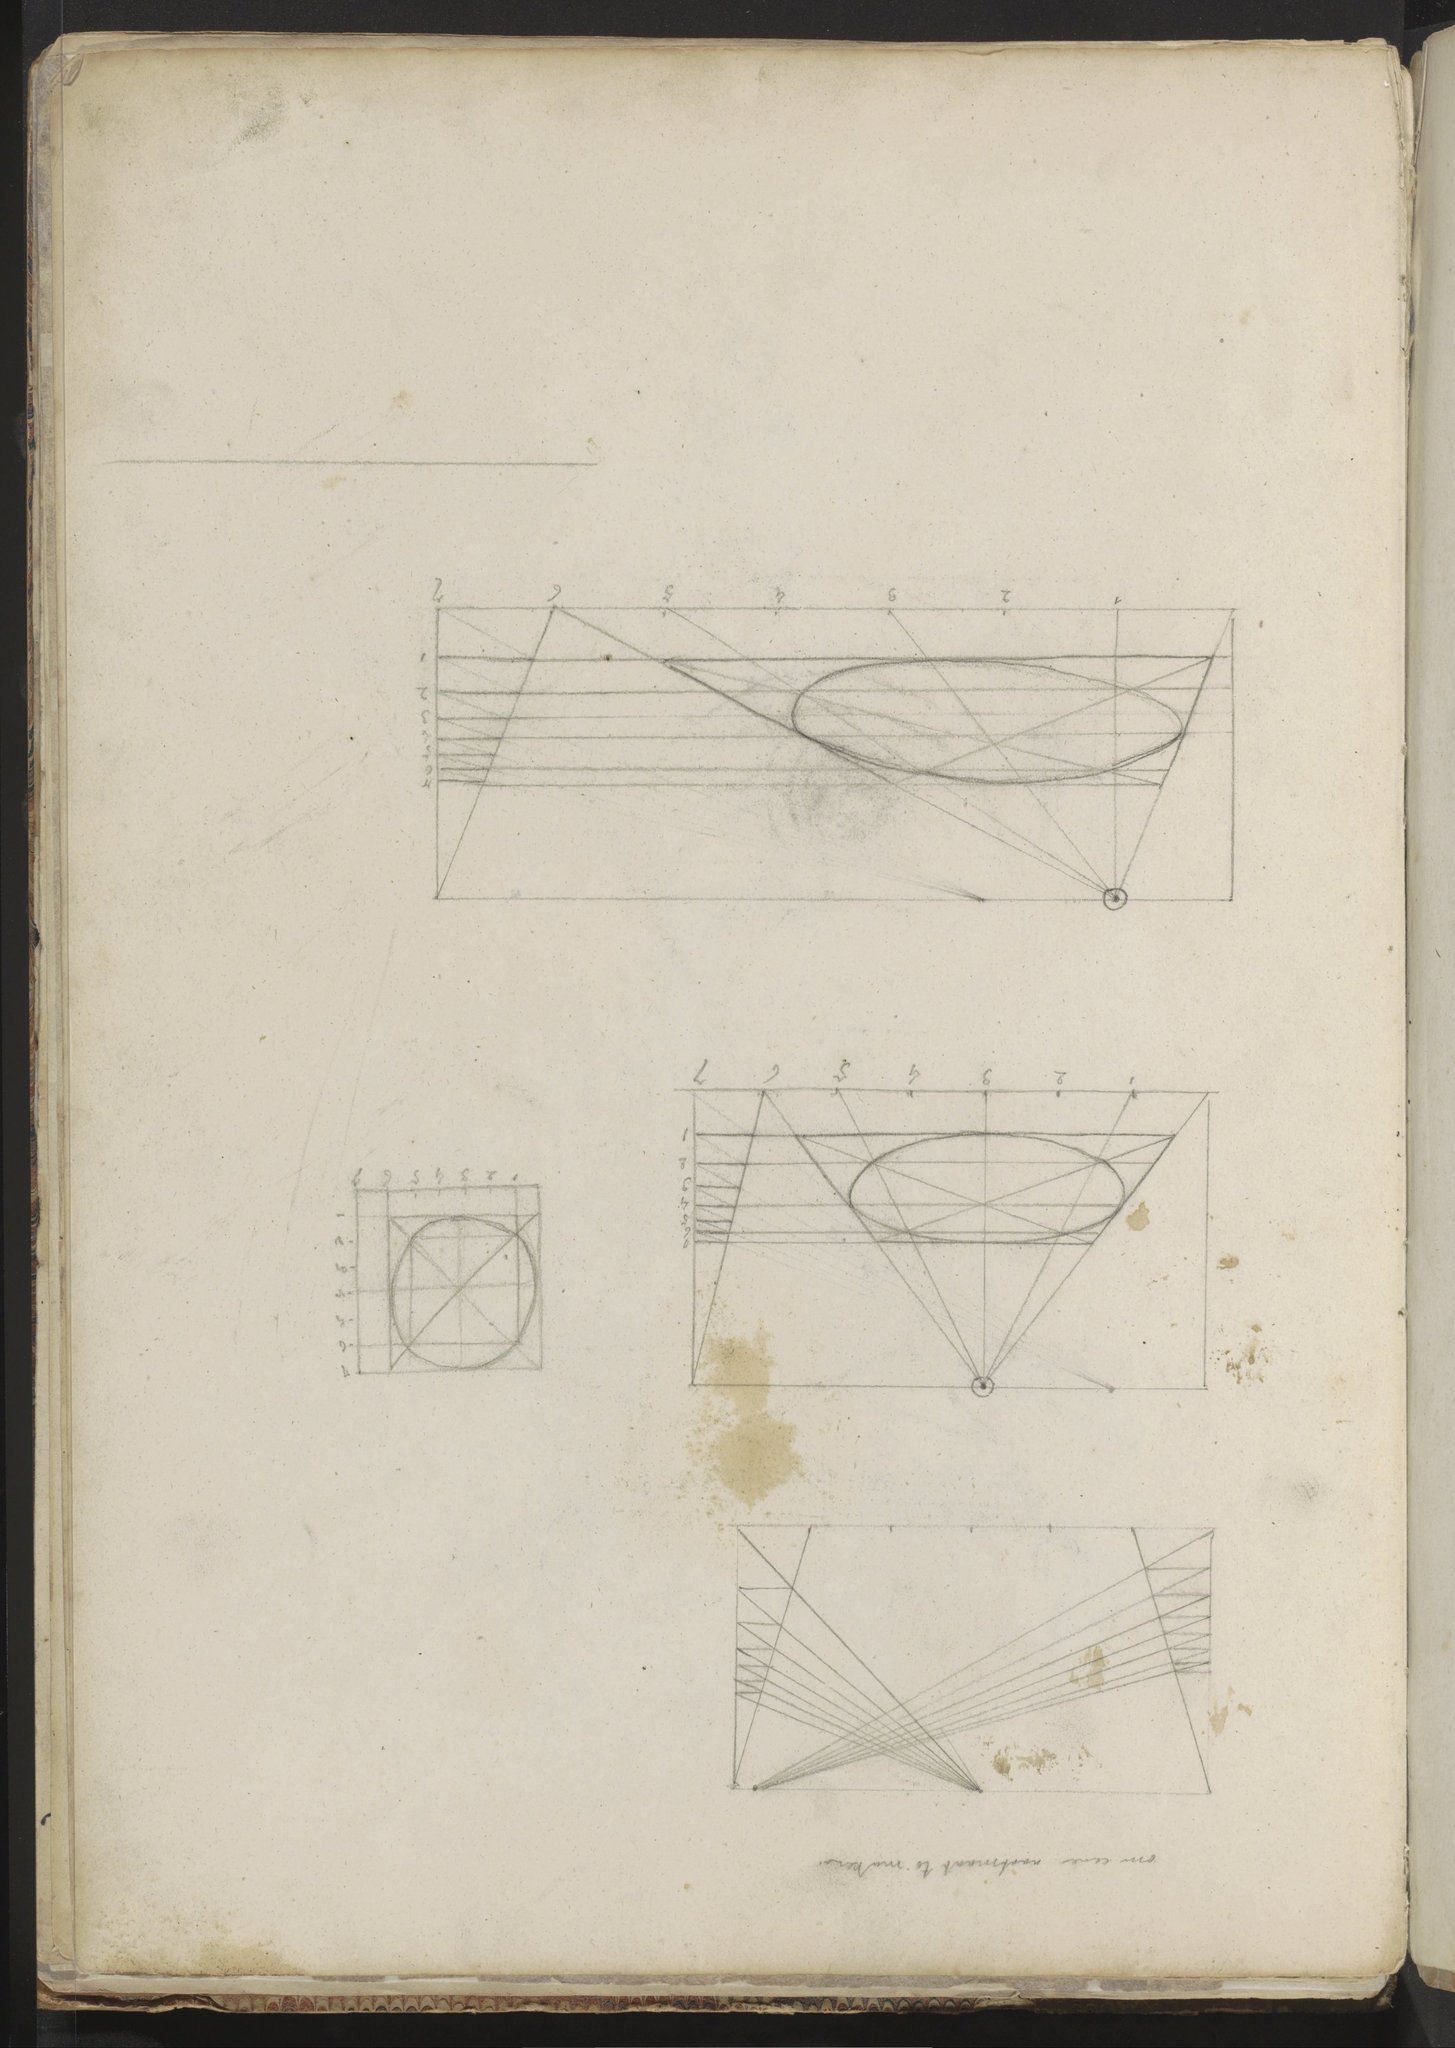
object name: sketchbook leaf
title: Mathematische tekeningen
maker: johannes huybertus van hove bzn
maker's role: print maker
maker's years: 1827-1881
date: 1837-1881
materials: paper, pencil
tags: drawing (mathematics)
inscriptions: annotation: ‘om eene n[...]tmaat te maken’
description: Blad 31 verso uit een schetsboek met 33 bladen en 10 losse tekeningen.